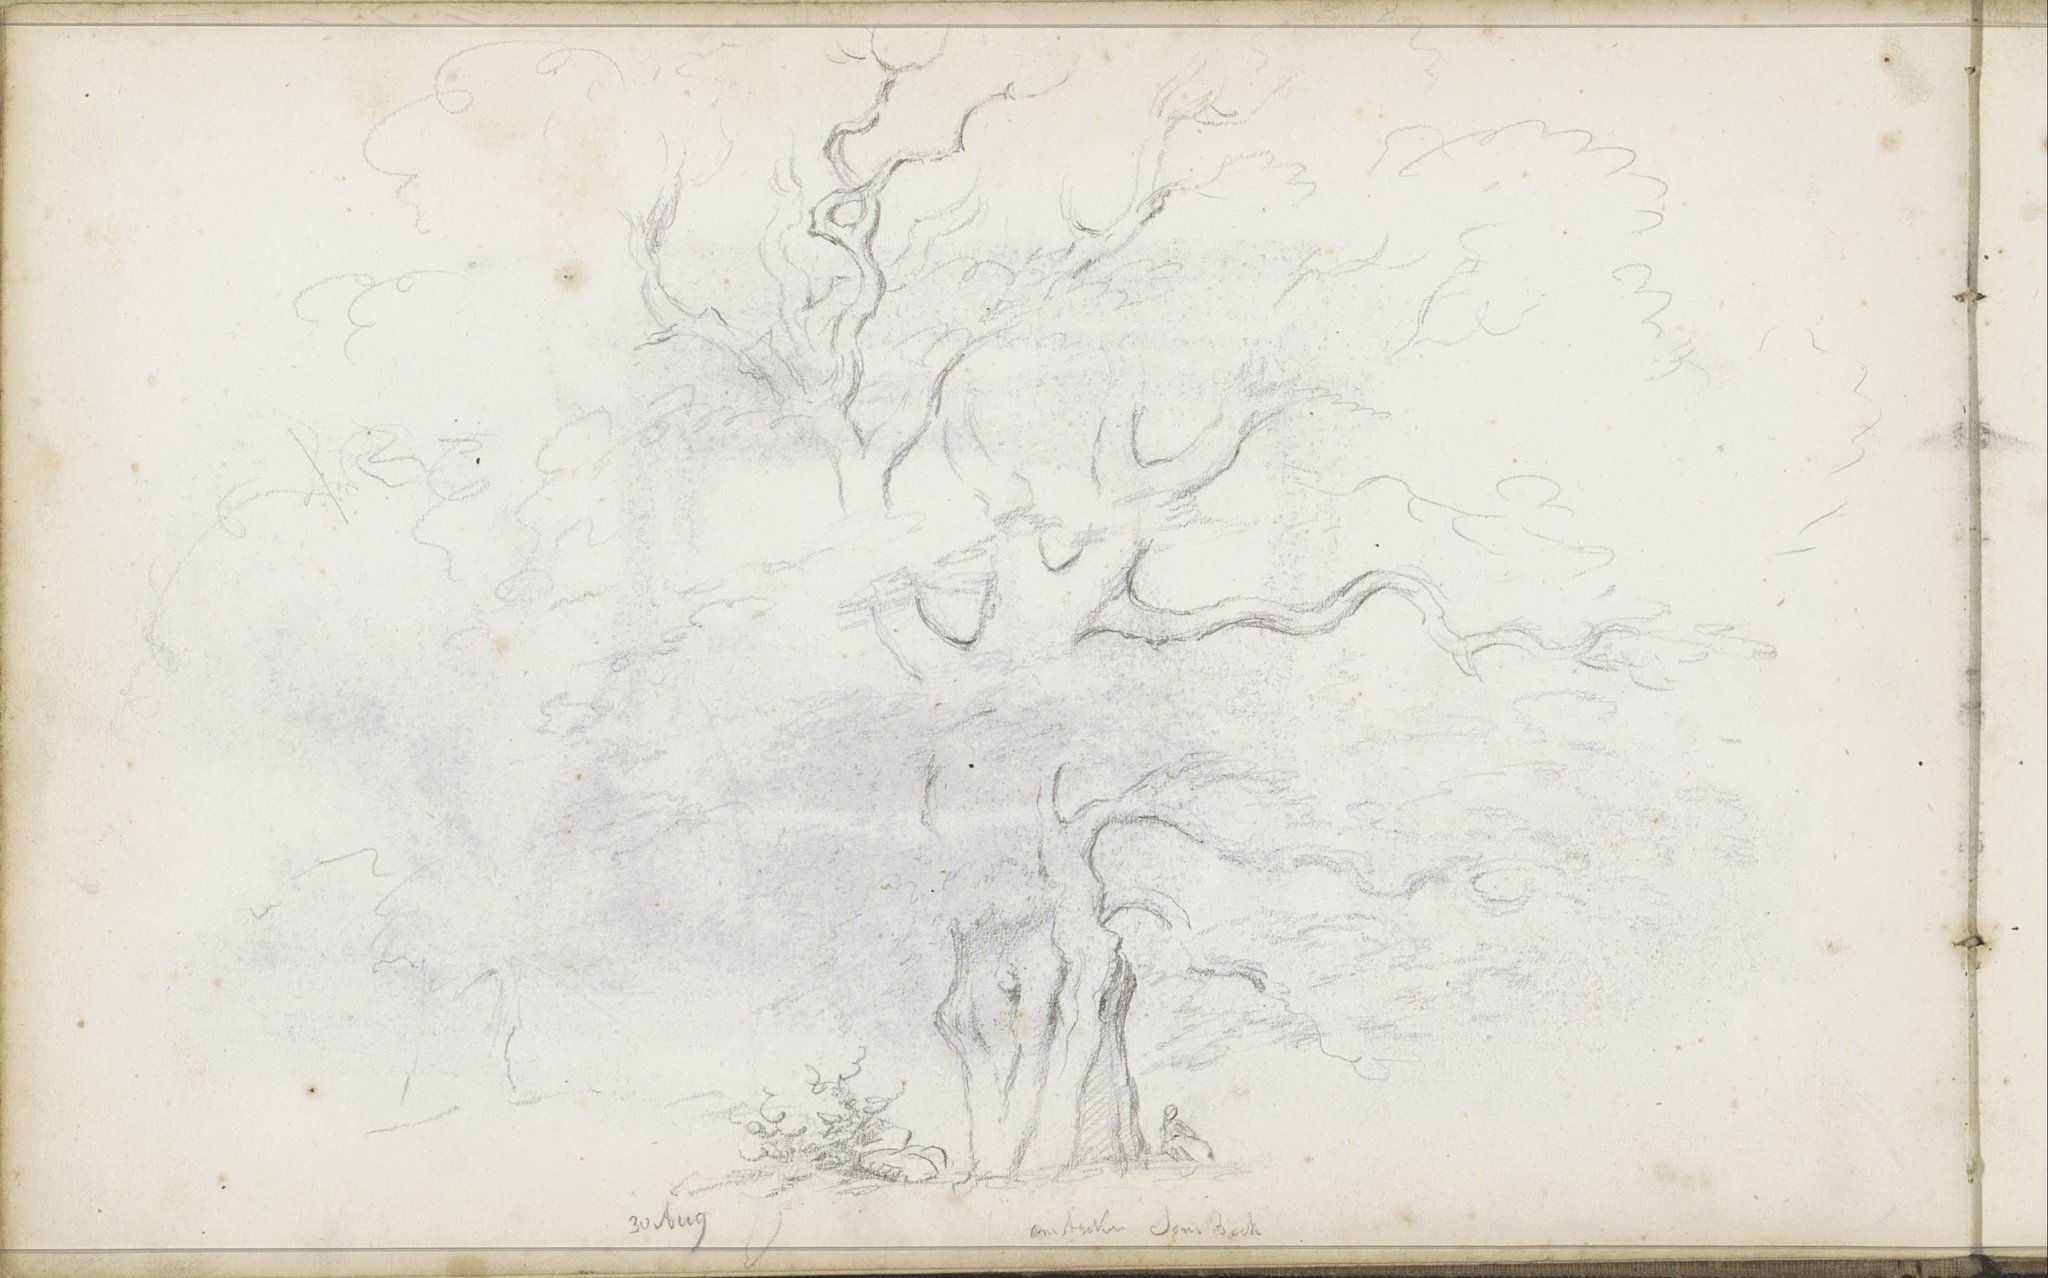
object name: sketchbook leaf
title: Rustende figuur onder een boom bij Sonsbeek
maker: willem cornelis rip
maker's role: draughtsman, painter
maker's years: 1856-1922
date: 1808-1874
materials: paper, pencil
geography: sonsbeek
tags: trees, (traveller) resting in the open air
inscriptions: date and inscription: ‘30 Aug omstreken Sonsbeek’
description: Blad 21 verso uit een schetsboek met 47 bladen.